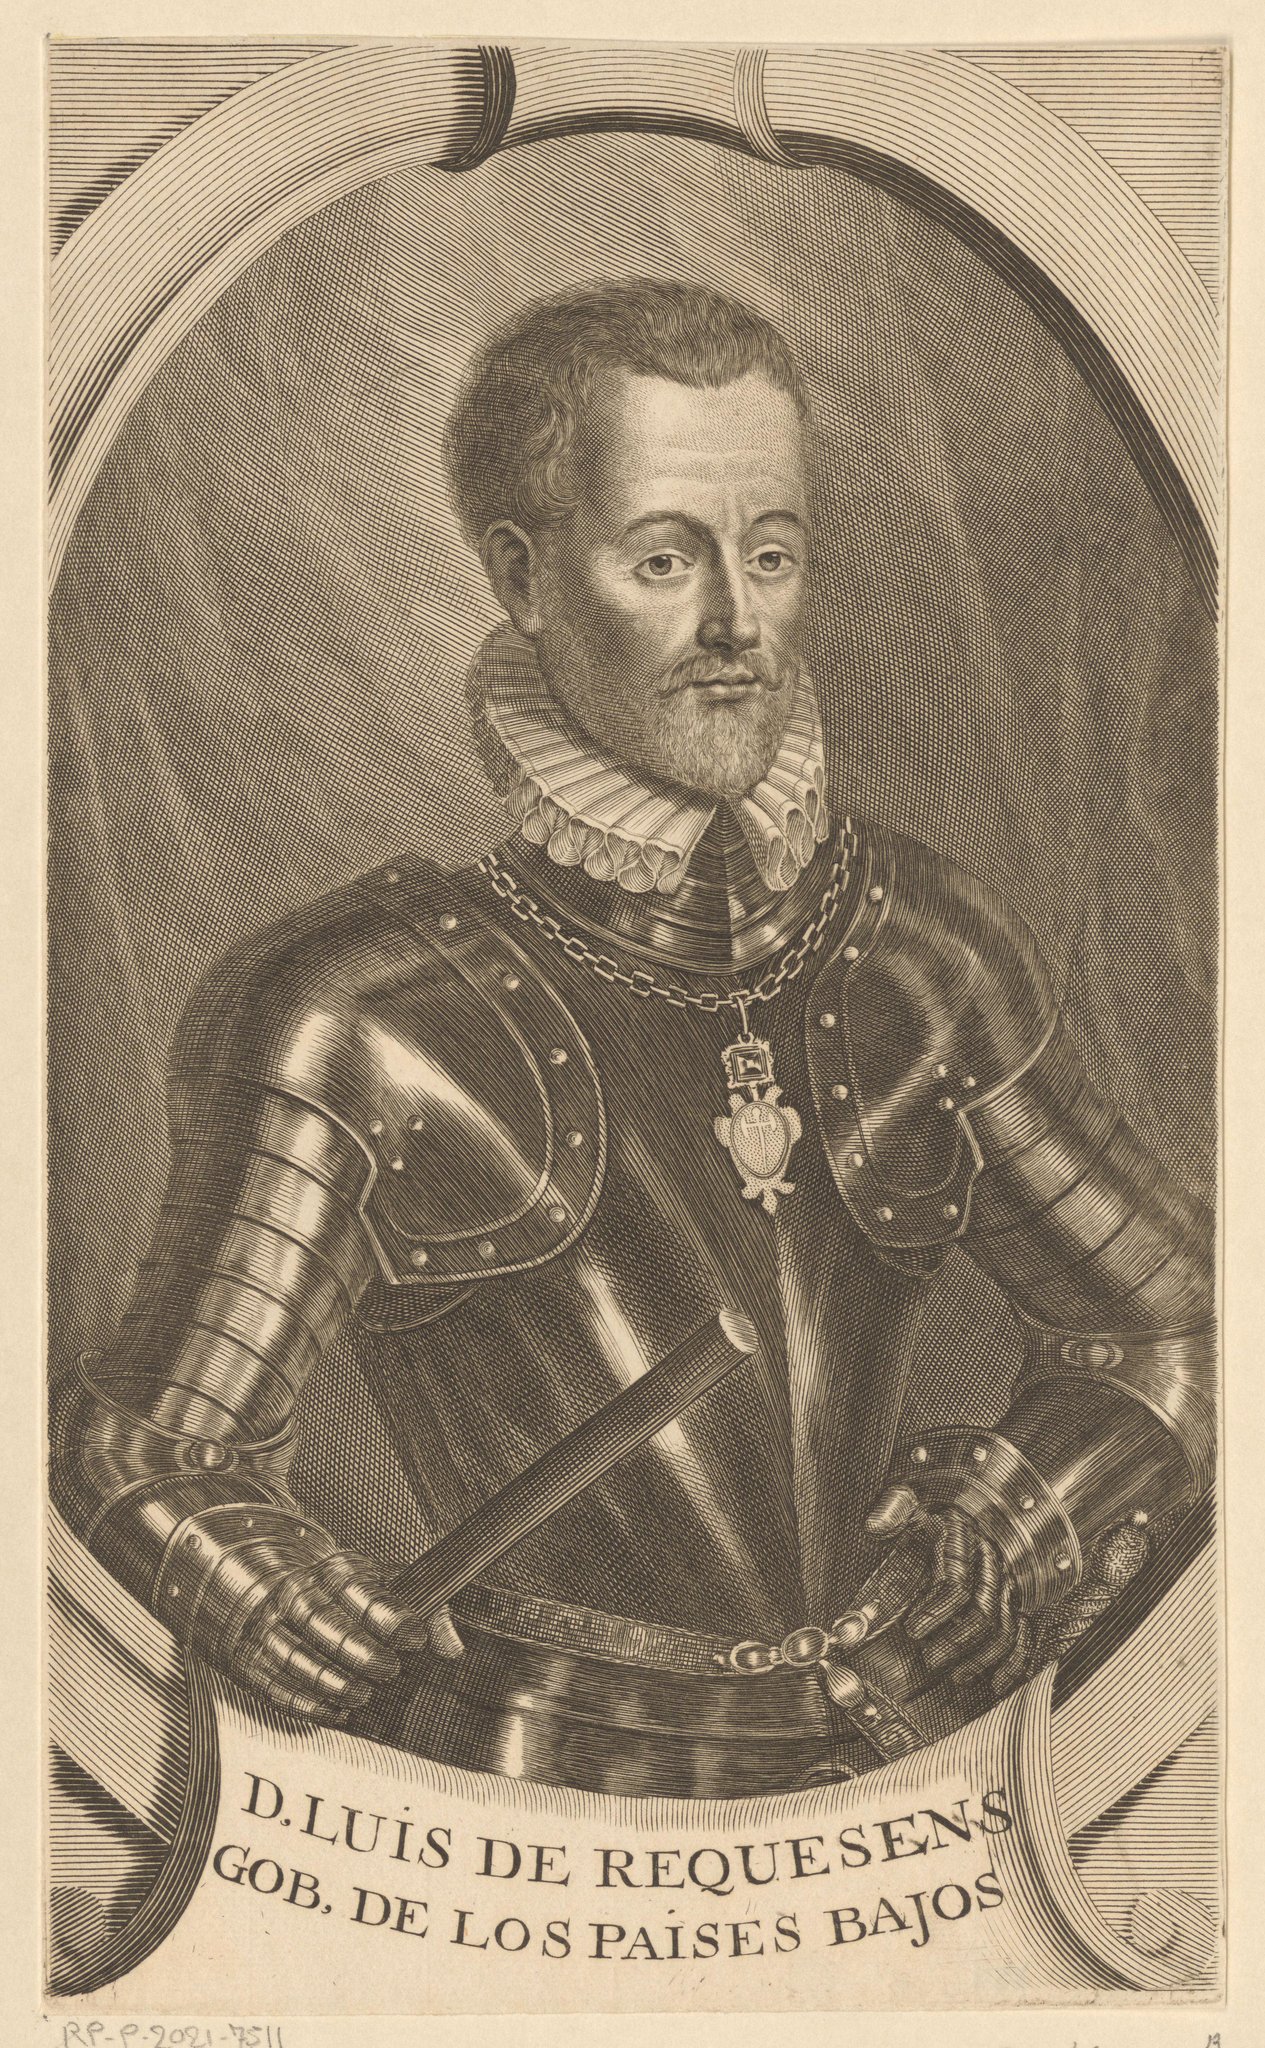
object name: print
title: Portret van Luis de Zúñiga y Requesens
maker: Anonymous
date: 1681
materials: paper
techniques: engraving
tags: brussels, mayor, luis de zúñiga y requesens, armour, historical persons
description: Prent mogelijk uit: Estrada, Famiano. Primera decada de las Guerras de Flandes (...). Keulen: s.n., 1681.